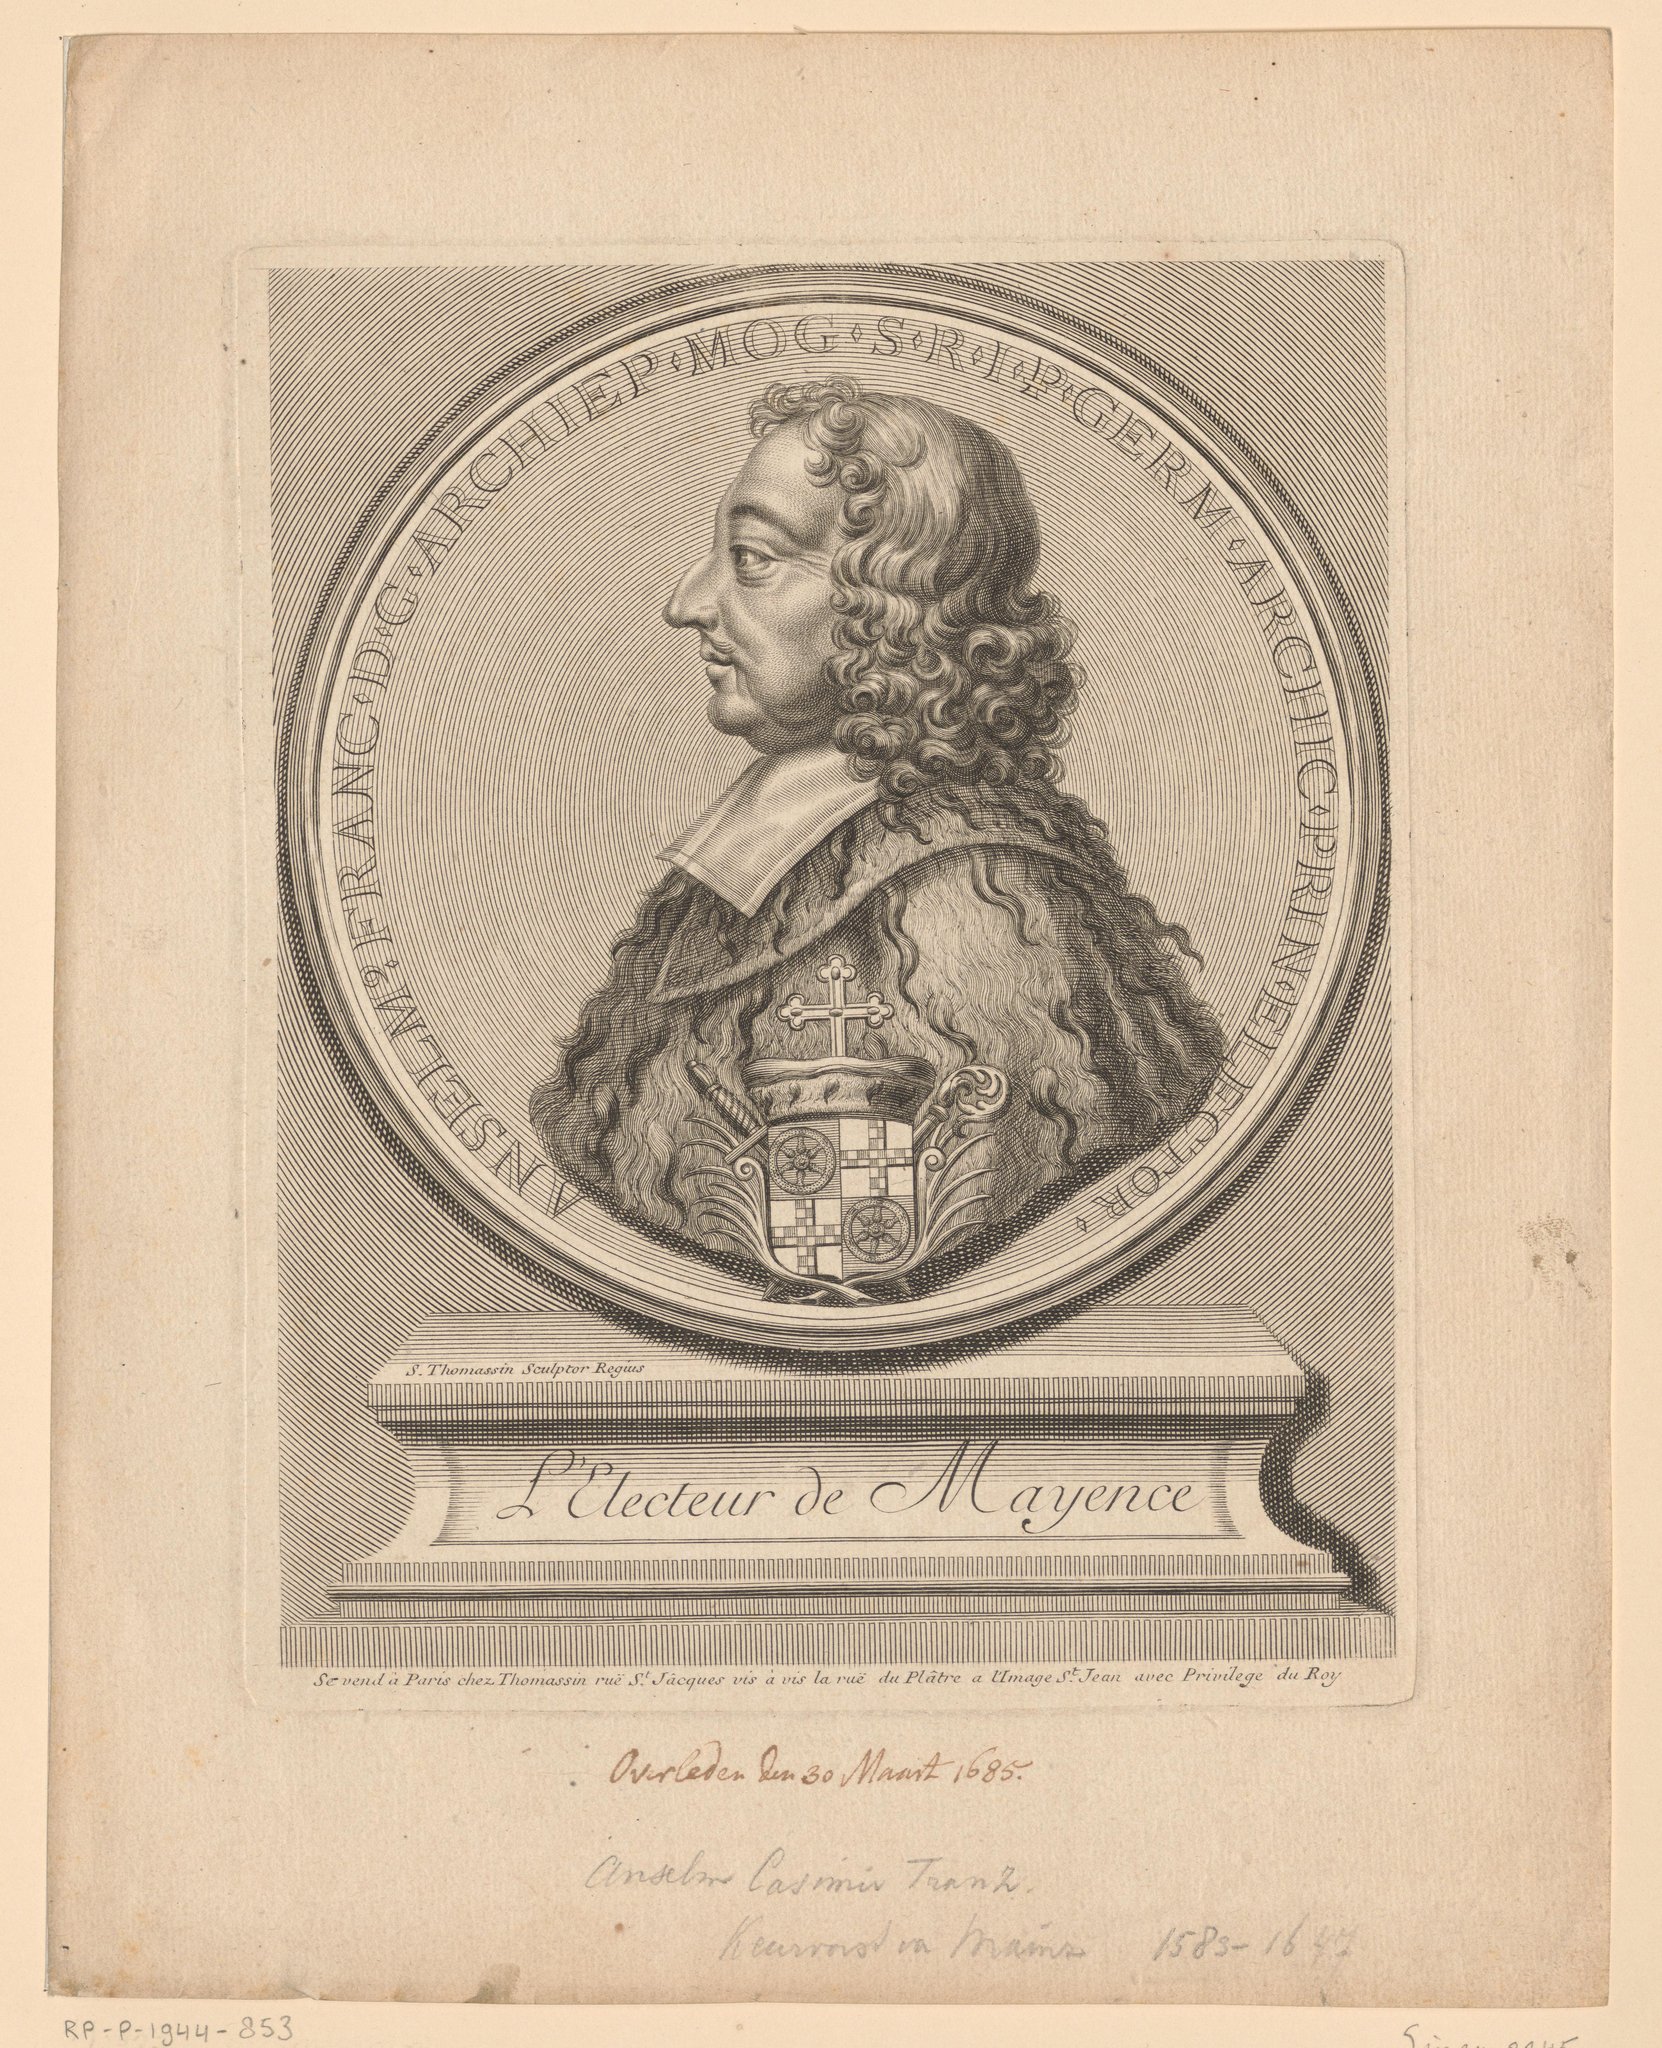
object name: print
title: Portret van Anselm Franz von Ingelheim, aartsbisschop-keurvorst van Mainz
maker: simon thomassin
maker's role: print maker, publisher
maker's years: 1655-1733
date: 1679-1733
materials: paper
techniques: engraving, etching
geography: paris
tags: cologne, ornament ~ medallion, historical persons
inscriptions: inscription: ‘Overleden den 30 Maart 1685.’, collector's mark: Lugt 2228